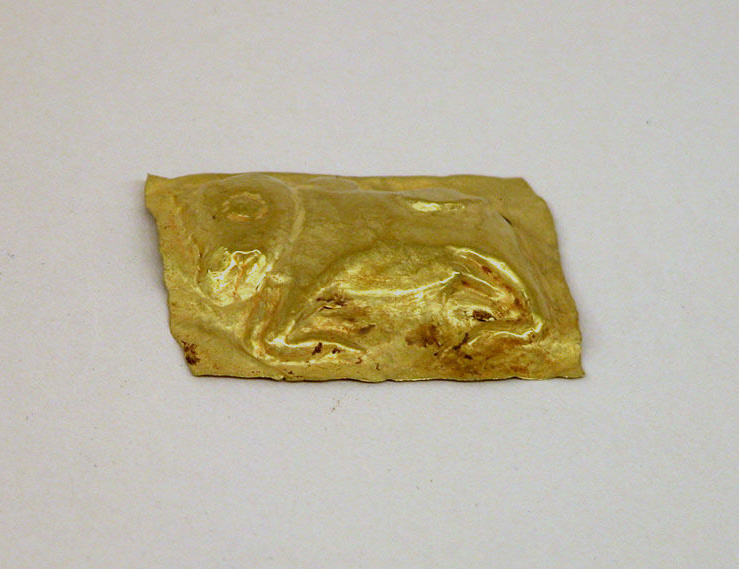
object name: plaque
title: Plaque with Depiction of Nandi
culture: indonesian, javanese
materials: gold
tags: bulls